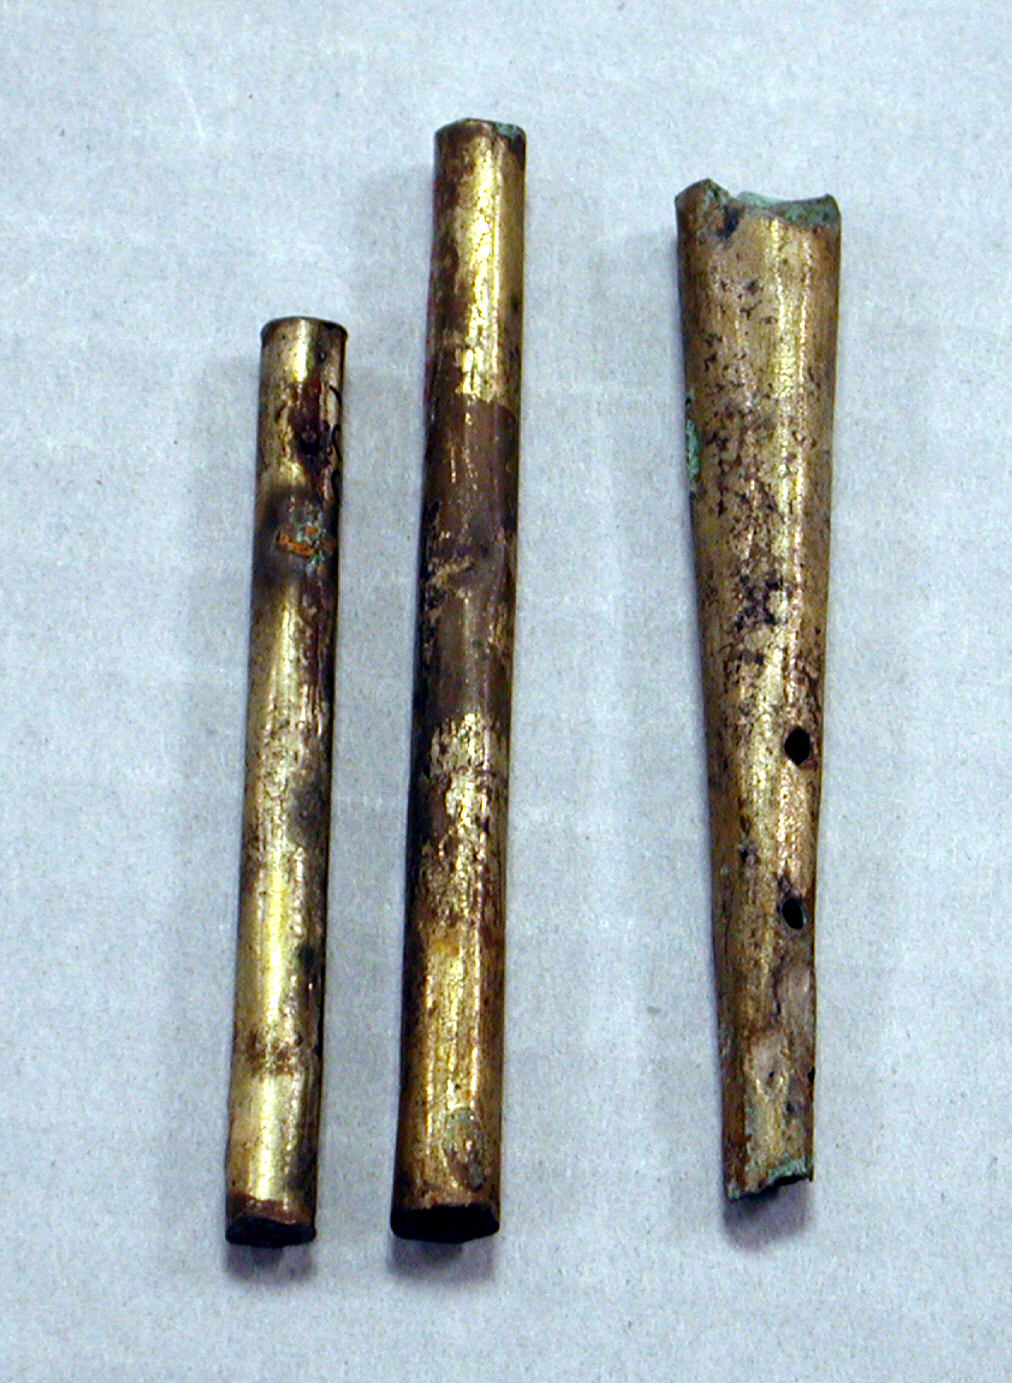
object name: ornament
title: Hammered Silver Tube Ornament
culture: peruvian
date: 701-1566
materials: gilt, silver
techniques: hammering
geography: peru